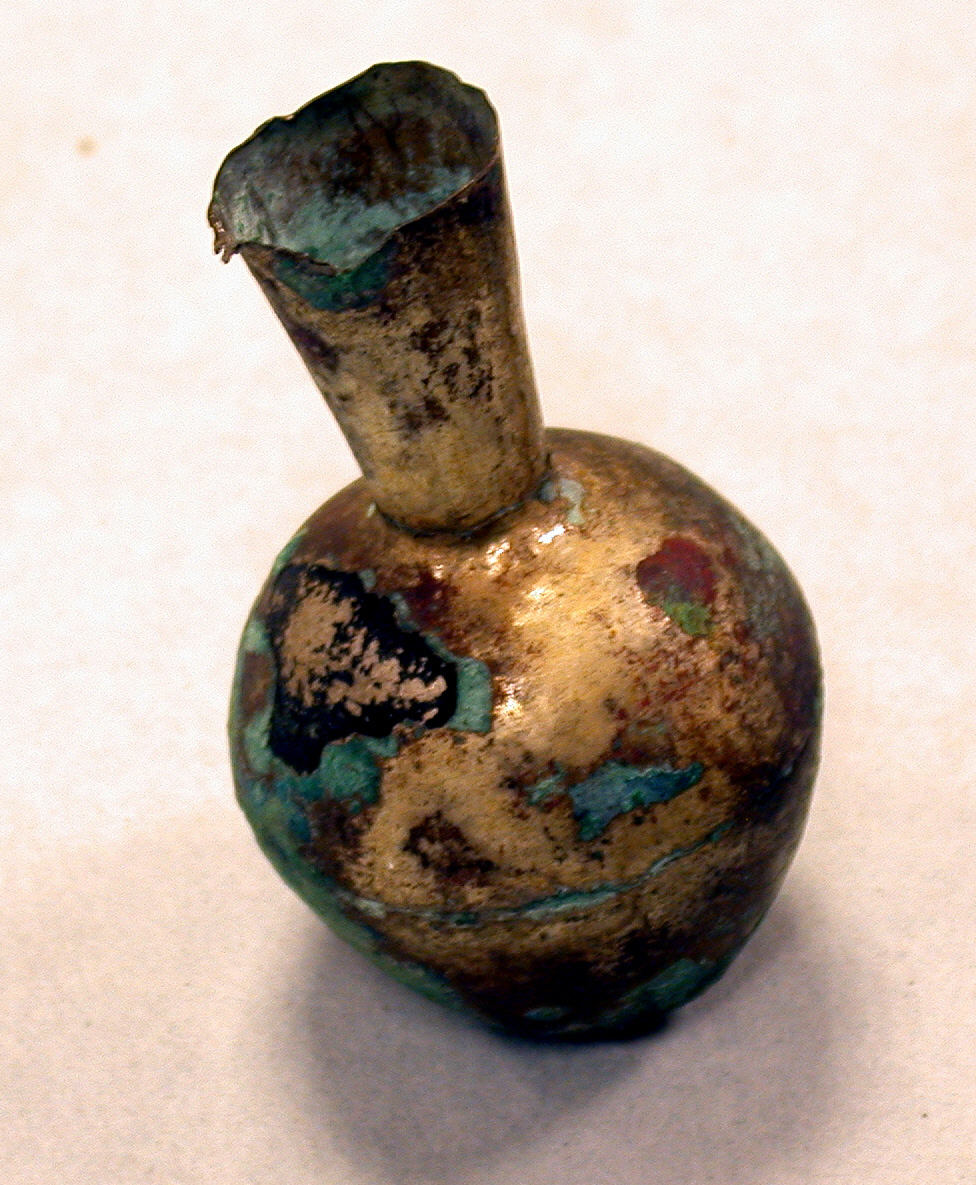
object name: bottle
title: Miniature Bottle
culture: chancay or chimú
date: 1001-1500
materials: copper, silver gilt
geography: peru